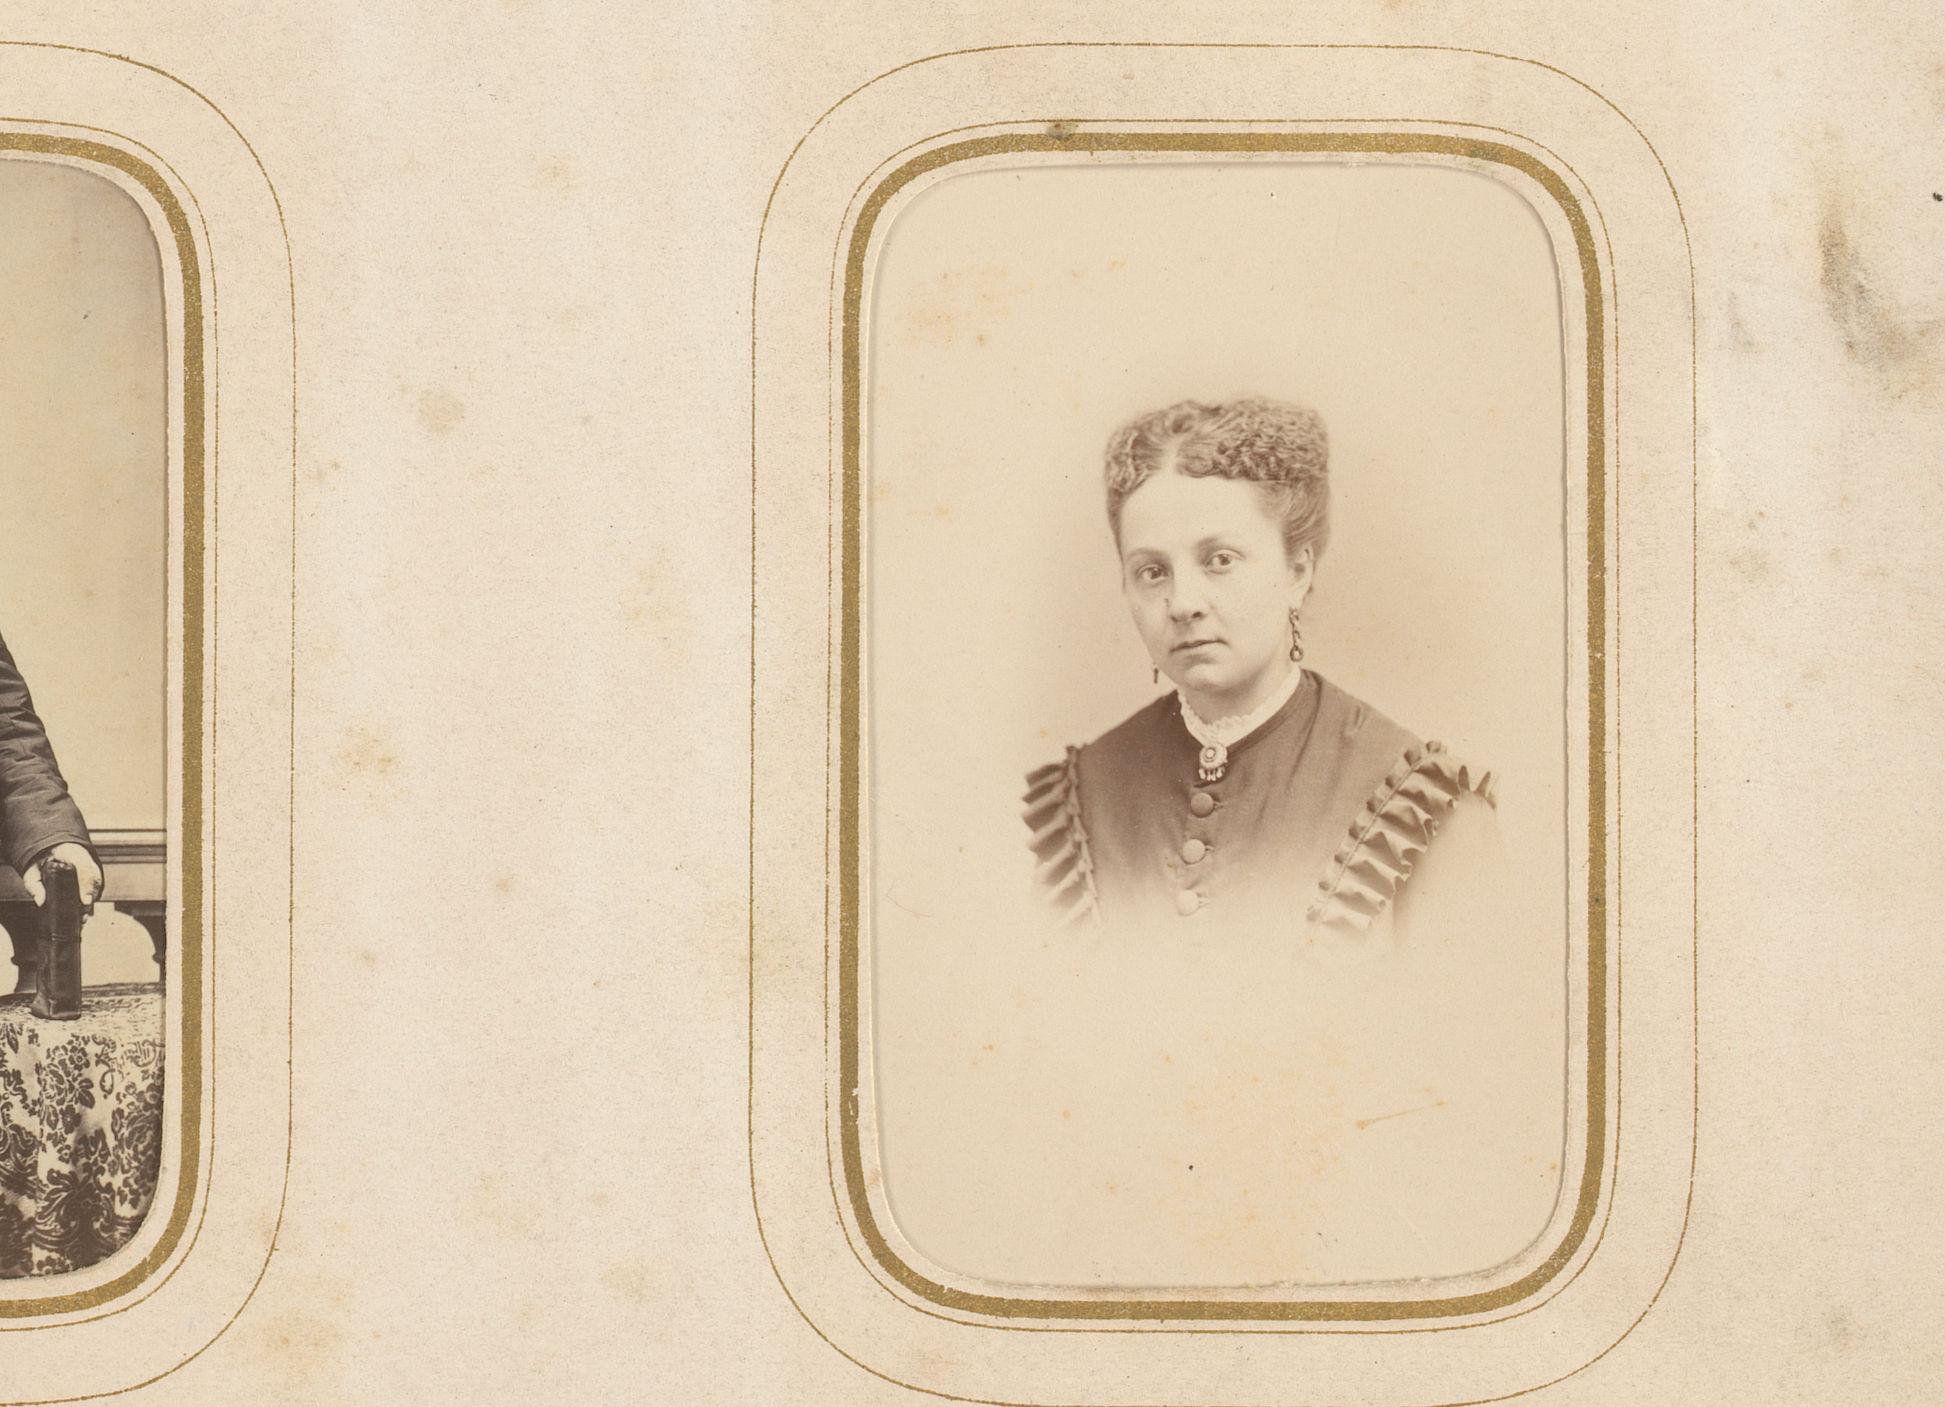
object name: album leaf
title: Portret van een vrouw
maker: victoire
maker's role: fotograaf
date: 1850-1867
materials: cardboard, photographic support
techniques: albumen print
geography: lyon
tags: historical persons - bb - woman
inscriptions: inscription: ‘Victoire/ E S: Pierre No 22/ Etage/ Lyon’